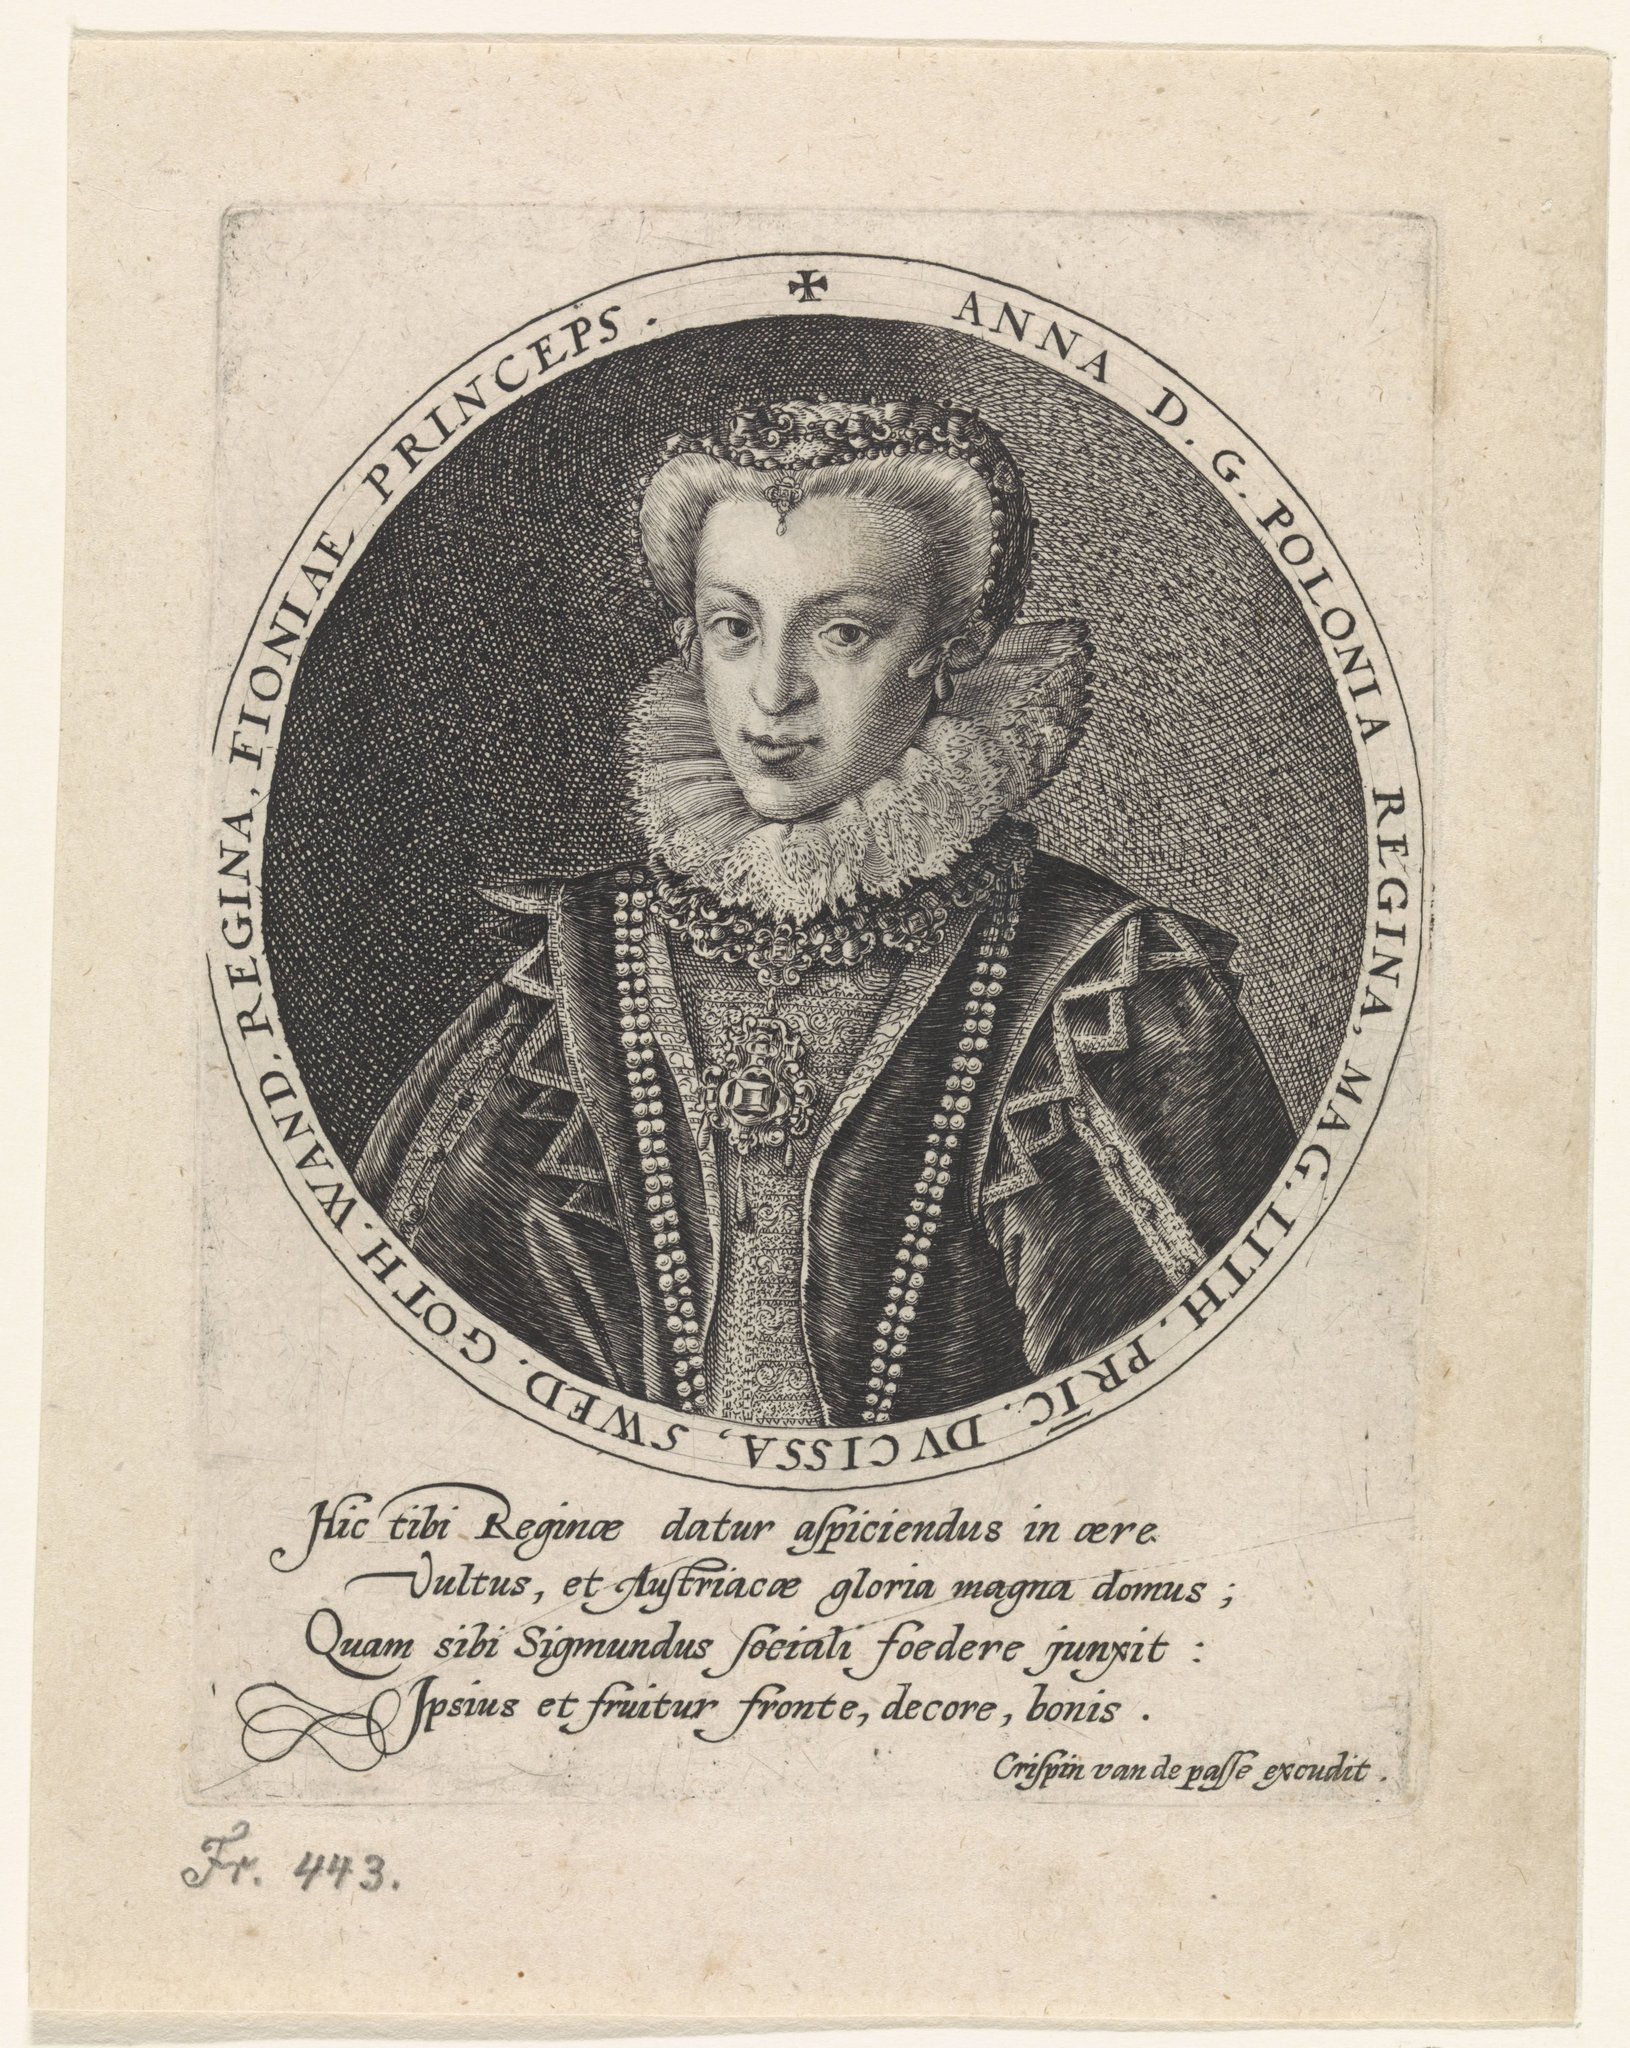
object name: print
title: Portret van Anna van Oostenrijk, koningin van Polen en Zweden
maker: crispijn van de passe (i)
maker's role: draughtsman, print maker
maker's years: 1564-1637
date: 1574-1637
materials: paper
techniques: engraving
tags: graz, warschau, koningin, anna van oostenrijk (koningin van polen en zweden)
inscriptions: collector's mark: Lugt 2228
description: Portret van Anna van Oostenrijk, gemalin van koning Sigismund III van Polen en Zweden. In het randschrift van de omlijsting de naam en functie van de geportretteerde in het Latijn. In de marge een vierregelig onderschrift in het Latijn.